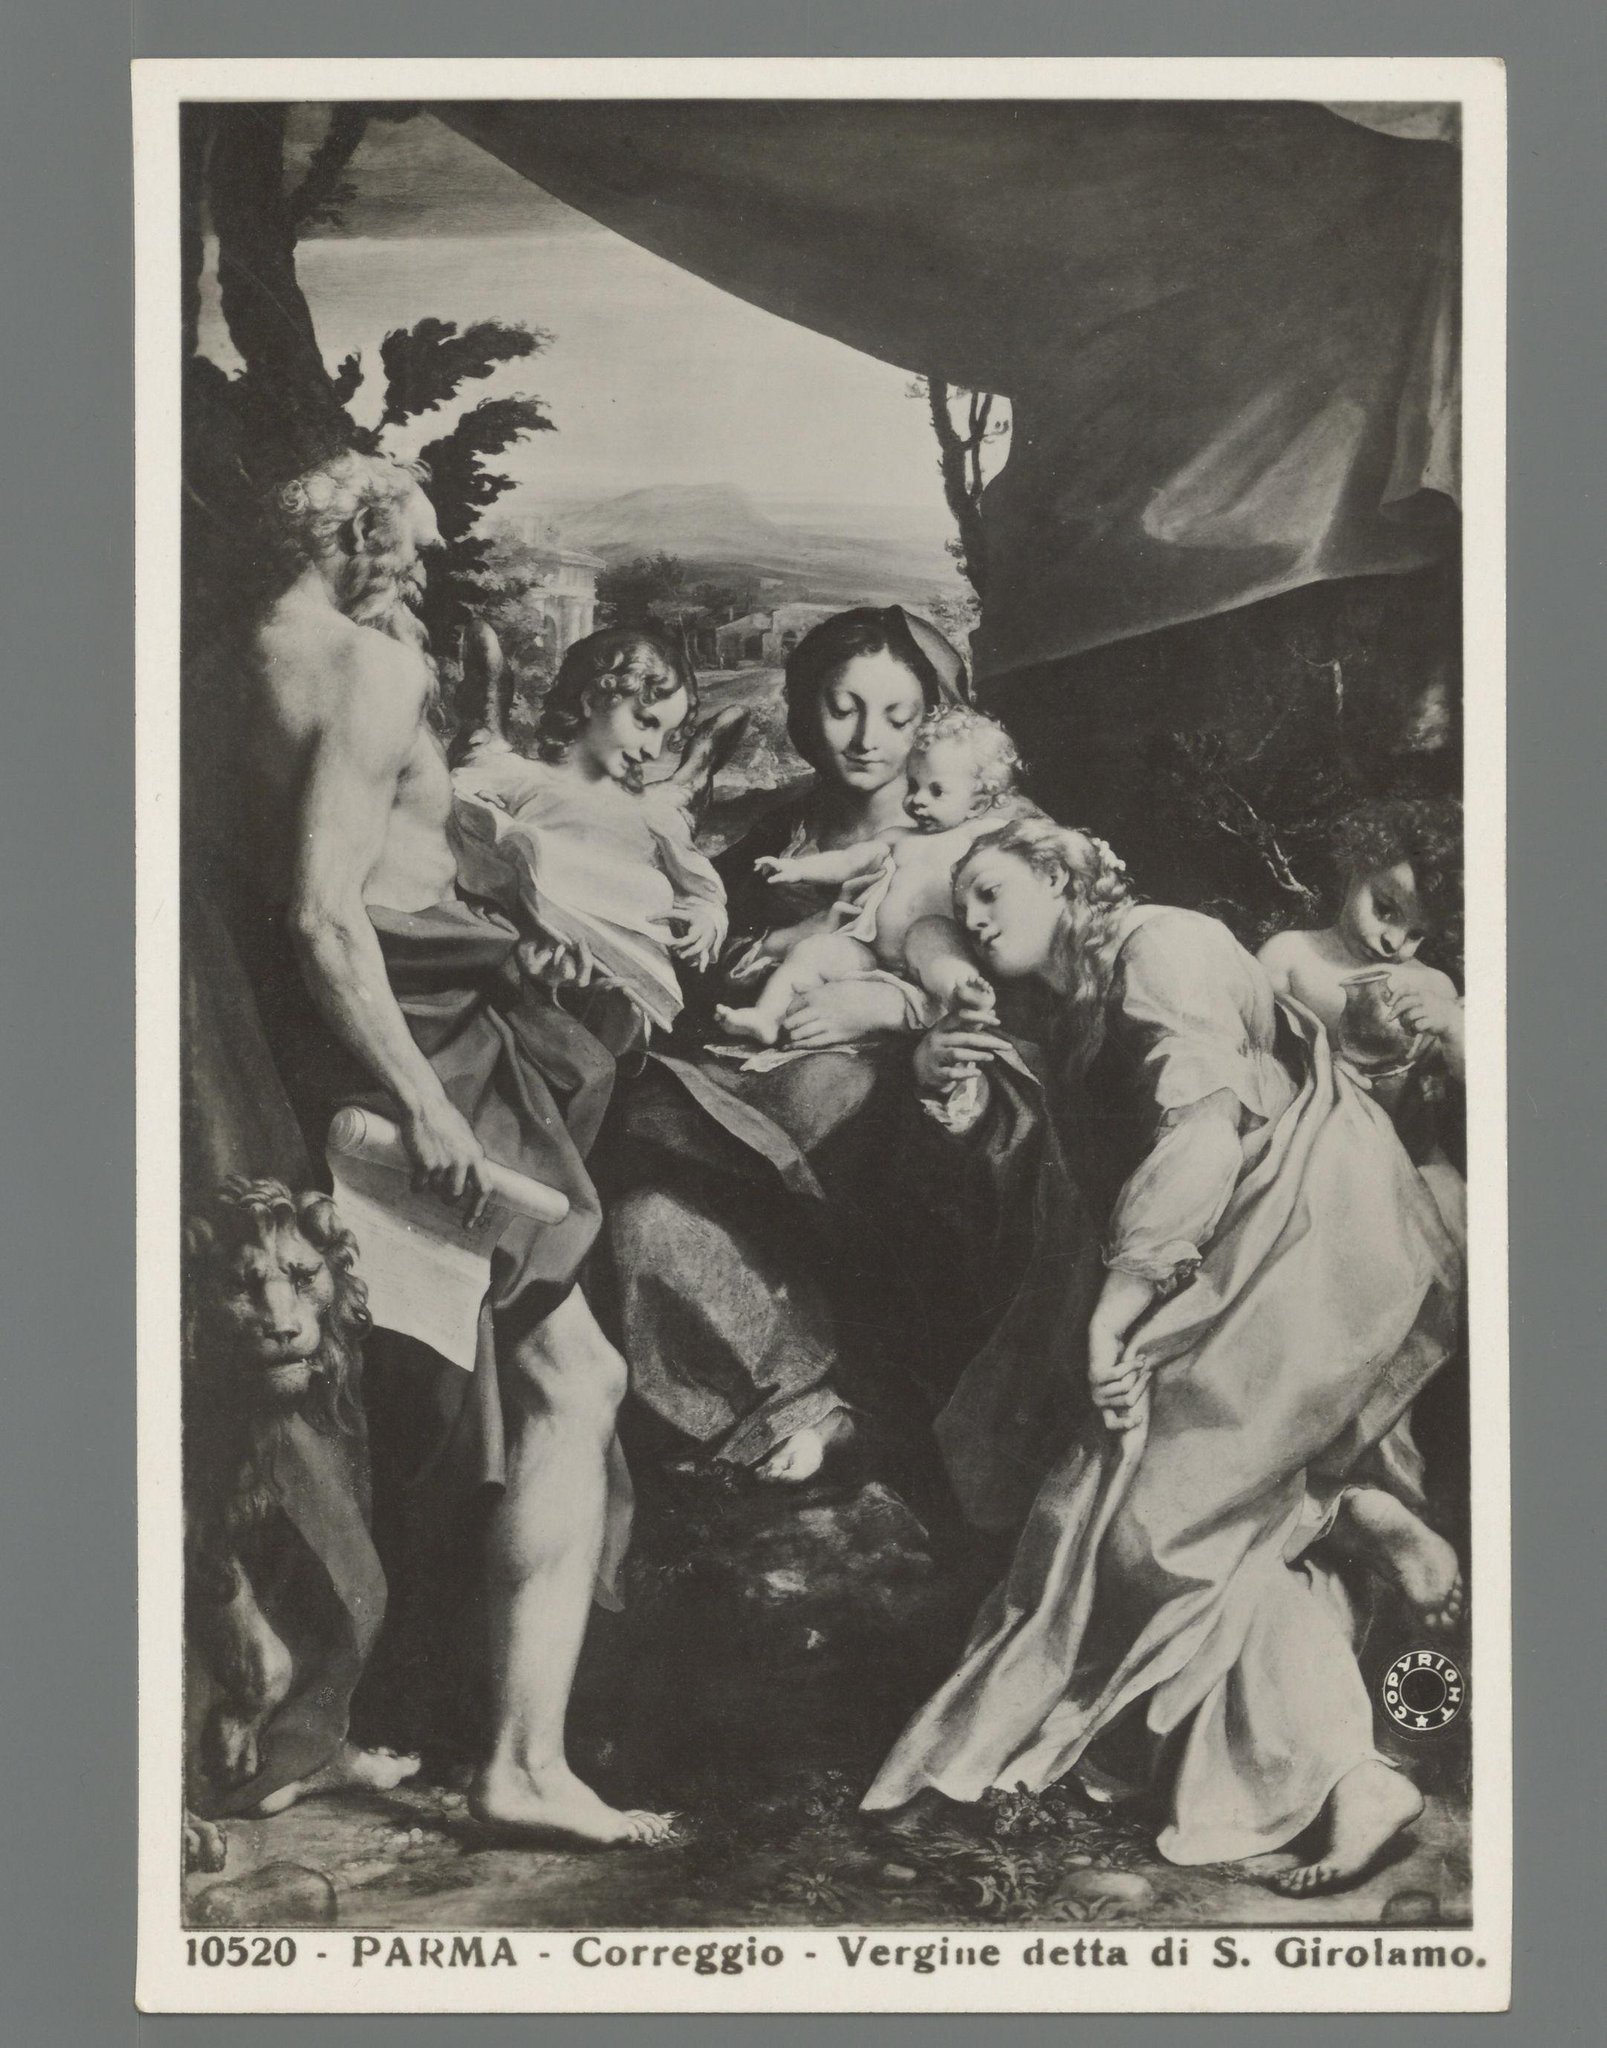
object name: ansichtkaart, prentbriefkaart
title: Vergine detta di S. Girolamo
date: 1905-1930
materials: photographic support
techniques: photography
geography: rome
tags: madonna: mary standing (or half-length), christ-child close to her bosom, the monk and hermit jerome (hieronymus); possible attributes: book, cardinal's hat, crucifix, hour-glass, lion, skull, stone